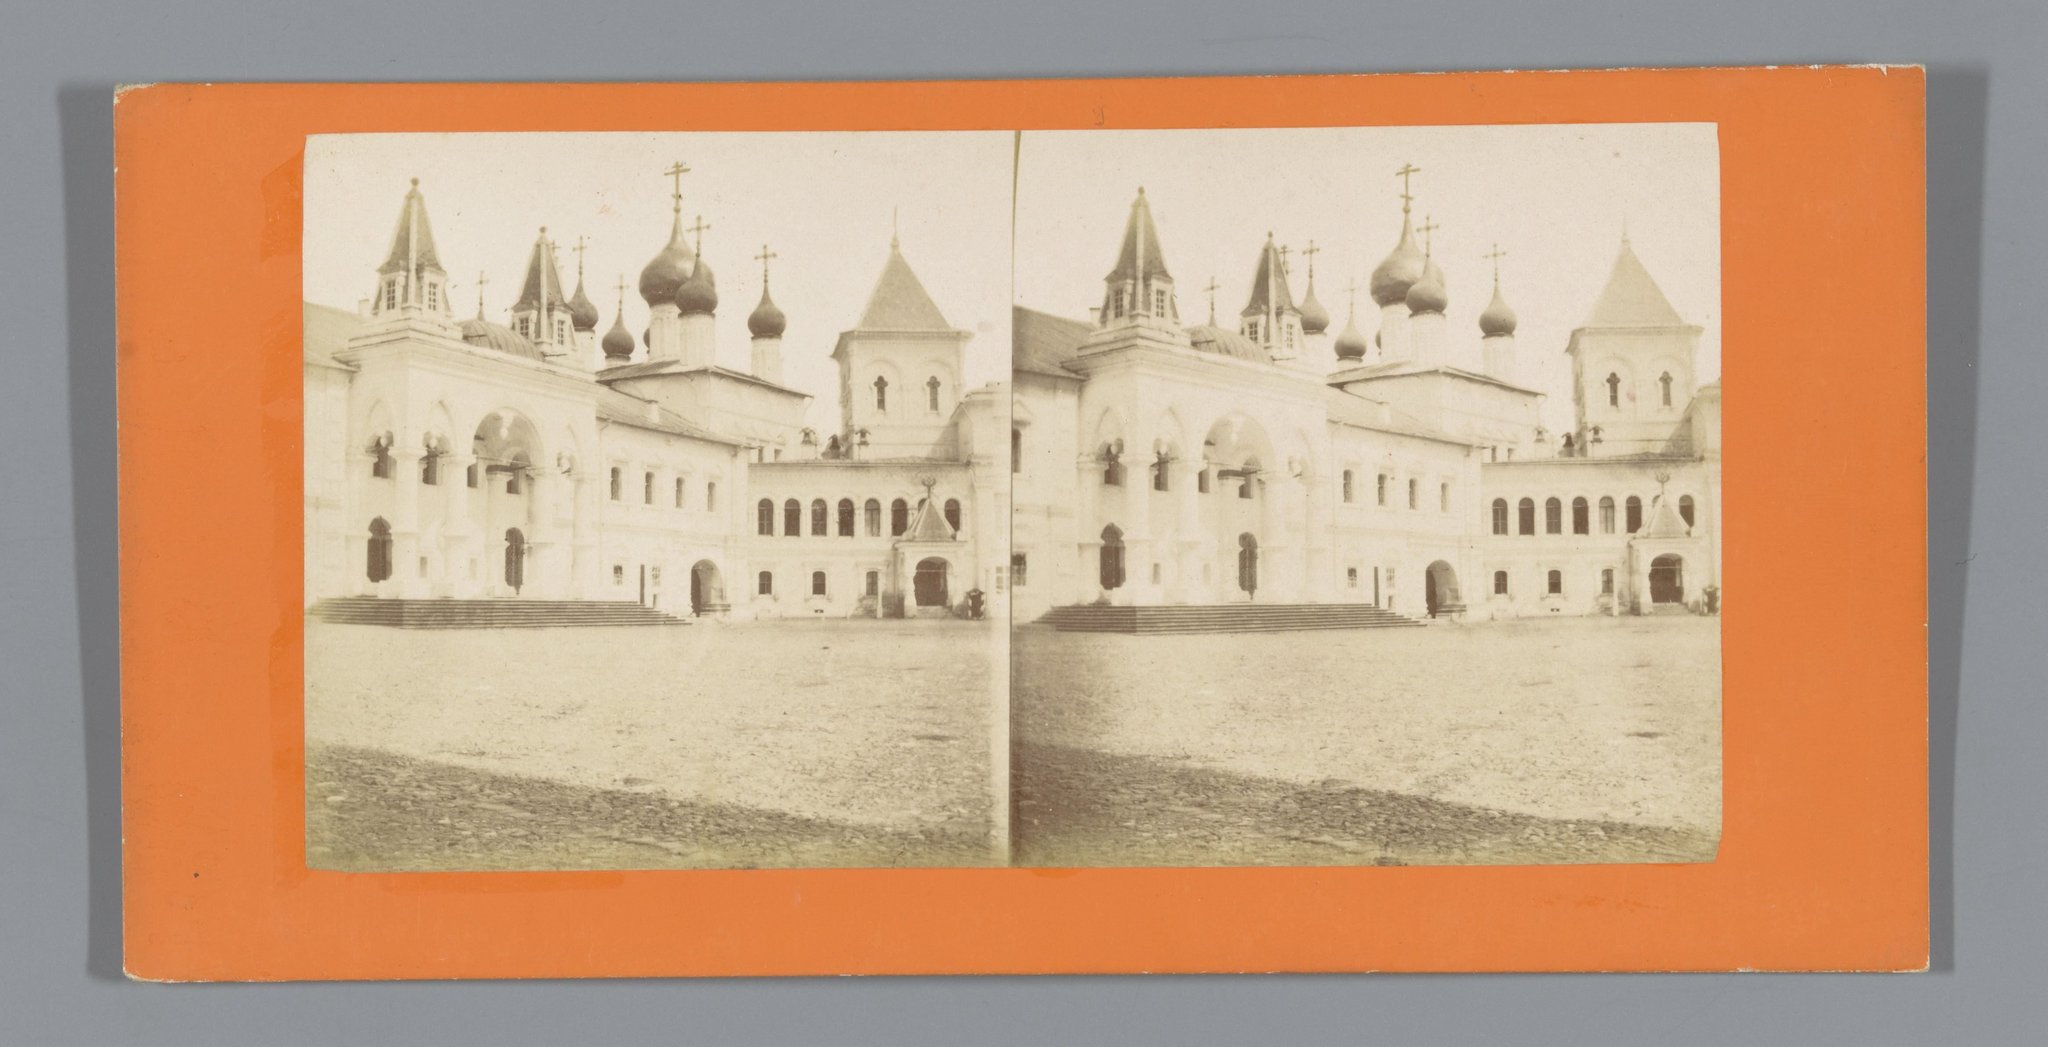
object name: stereograph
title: Binnenplaats van het Hemelvaartklooster in het Kremlin te Moskou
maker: Anonymous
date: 1850-1880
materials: cardboard, photographic support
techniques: albumen print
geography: moscow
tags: cloisters ~ monastery, courtyard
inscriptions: inscription: ‘44 Couvent de l'ascension Moscou’